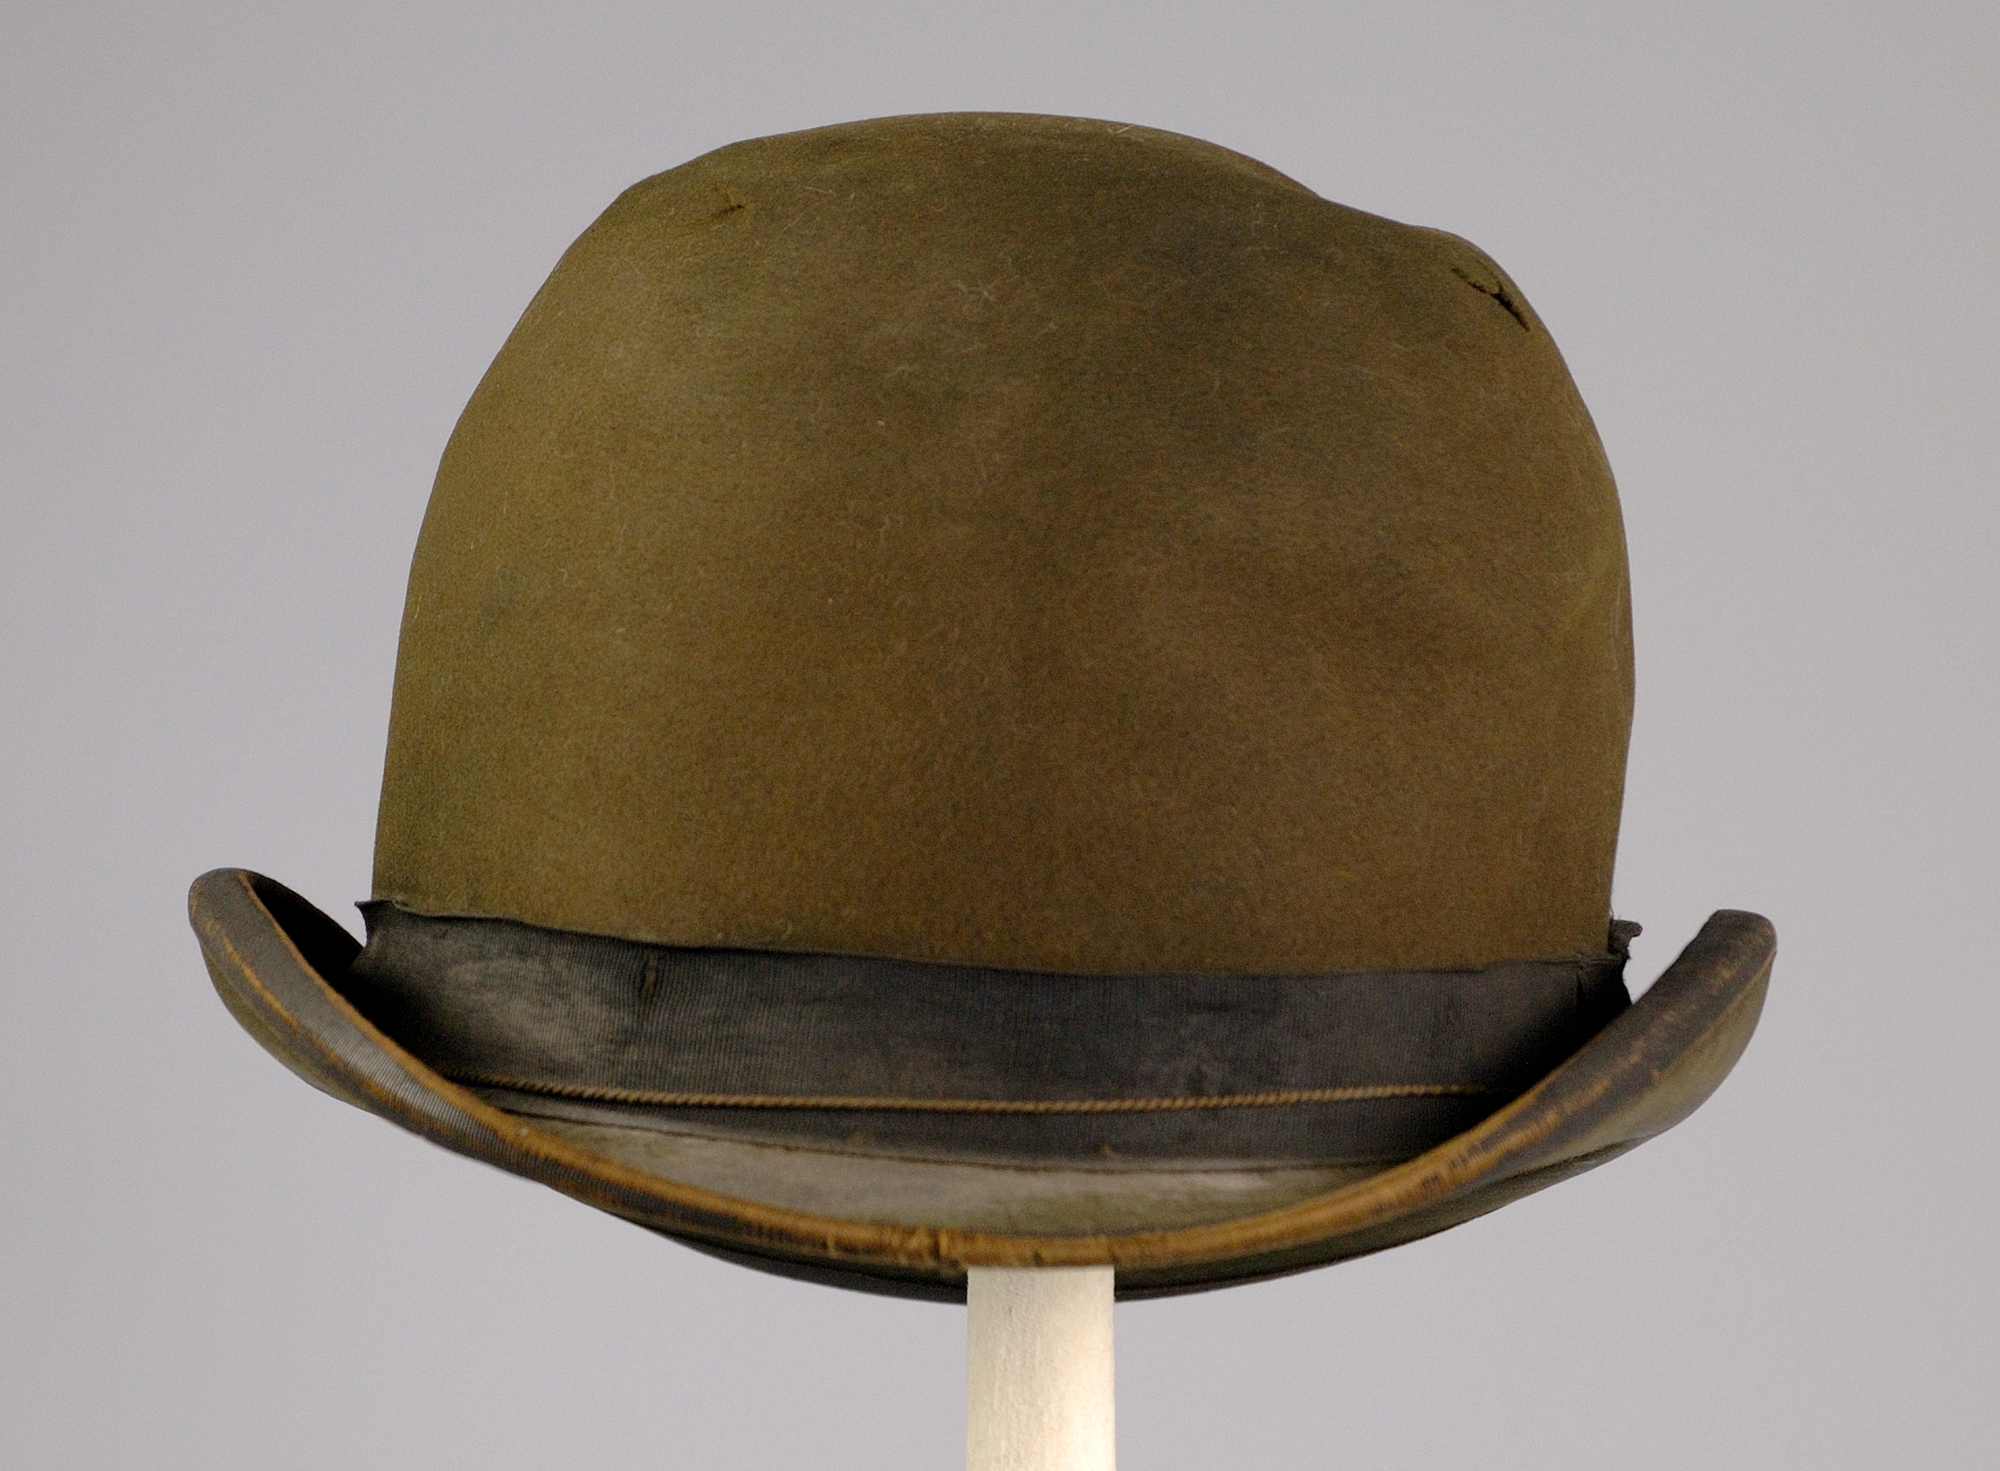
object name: derby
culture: russian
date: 1865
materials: silk, wool